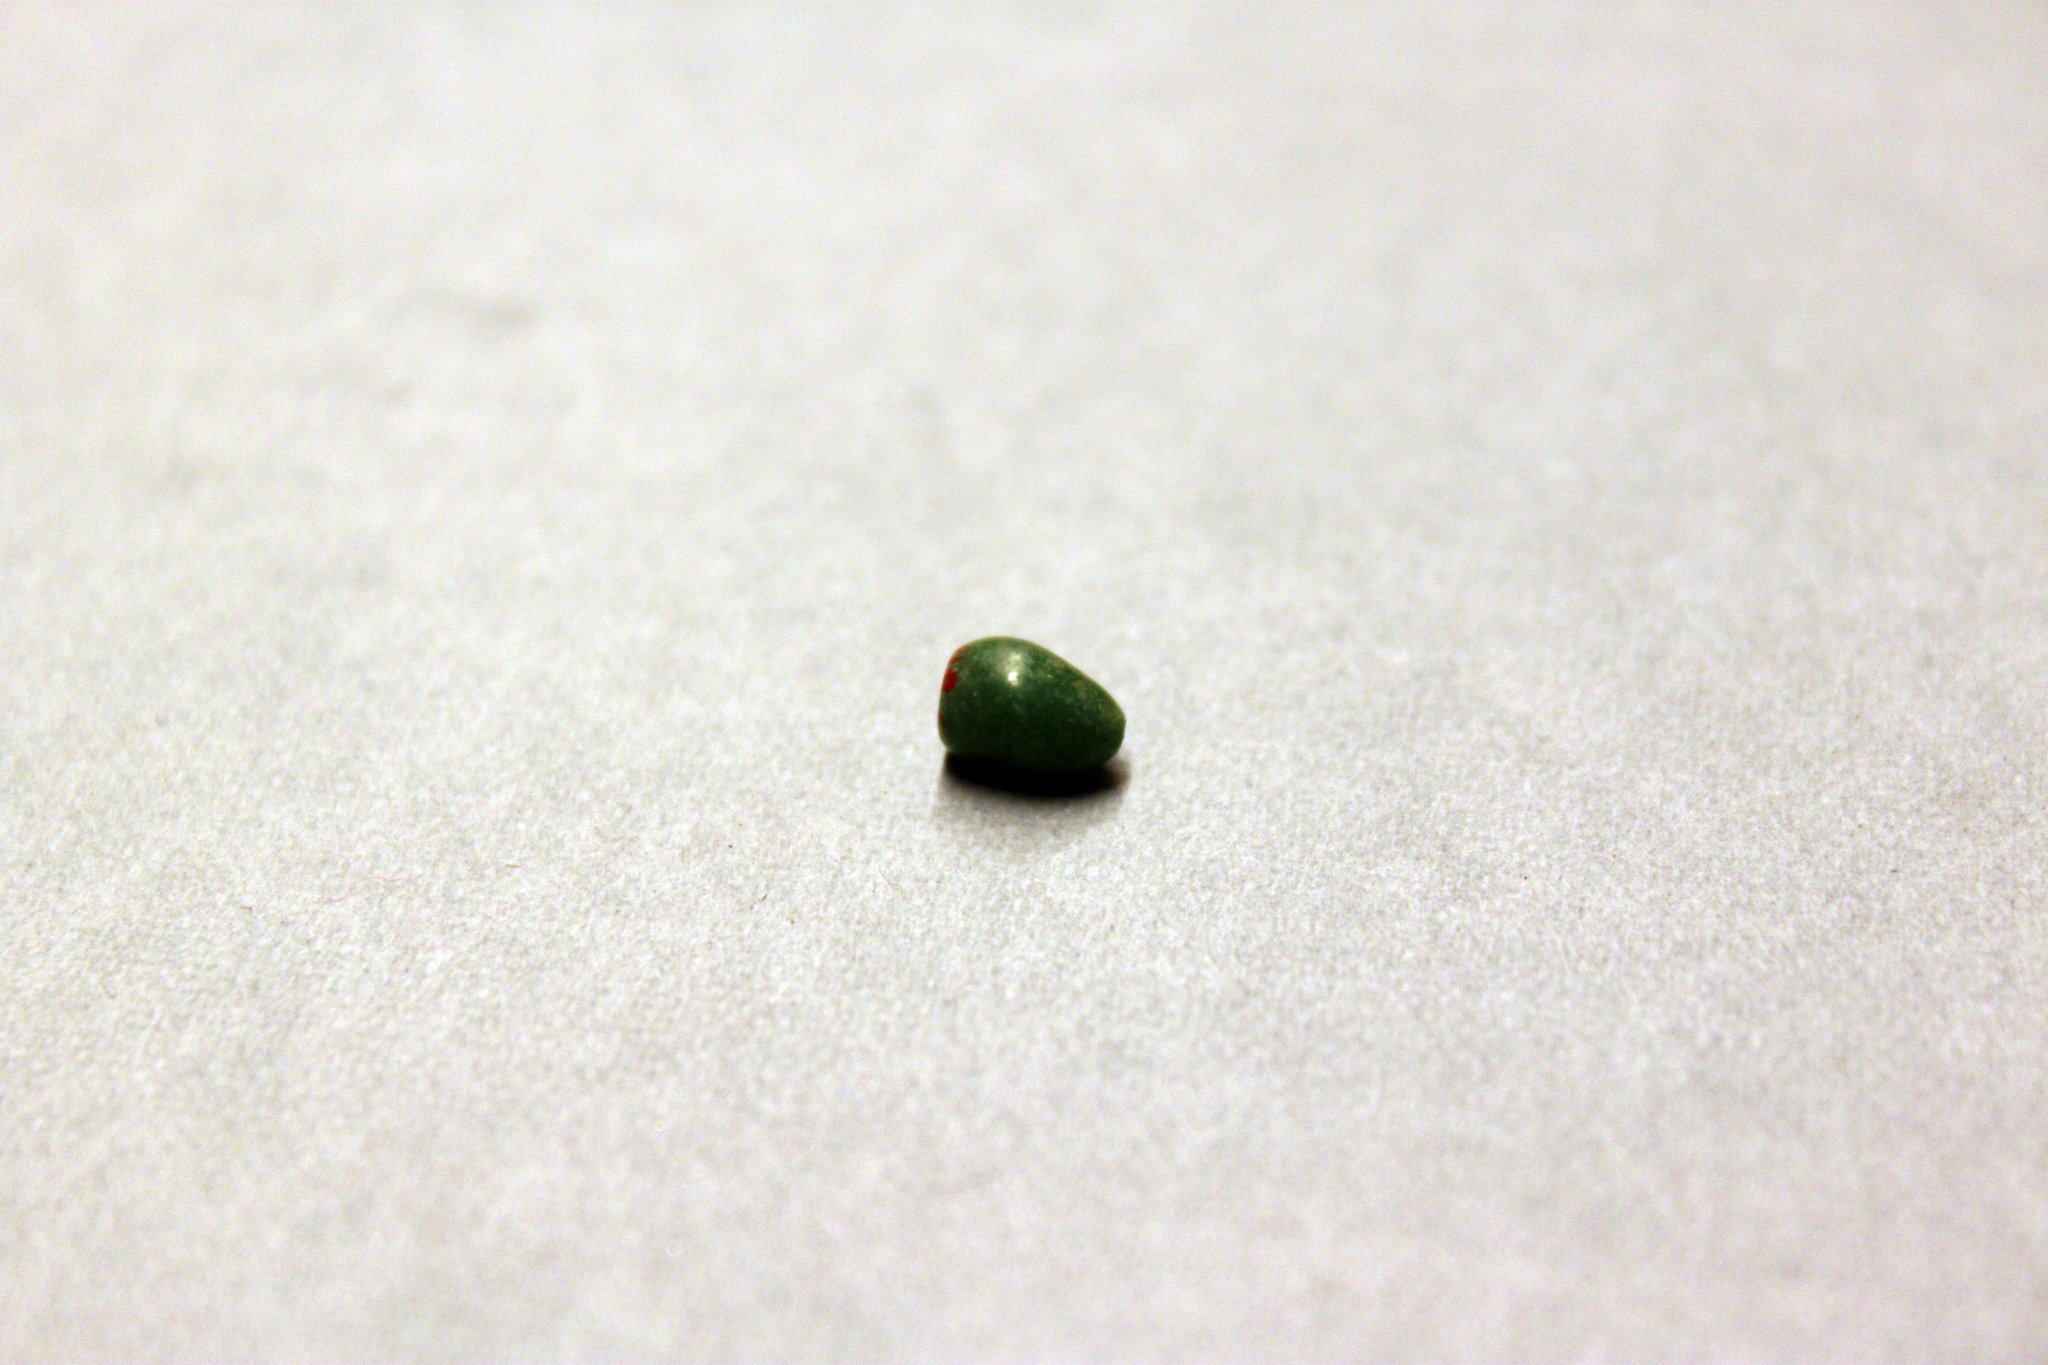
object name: bead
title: Beads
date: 701-1300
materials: glass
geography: iran